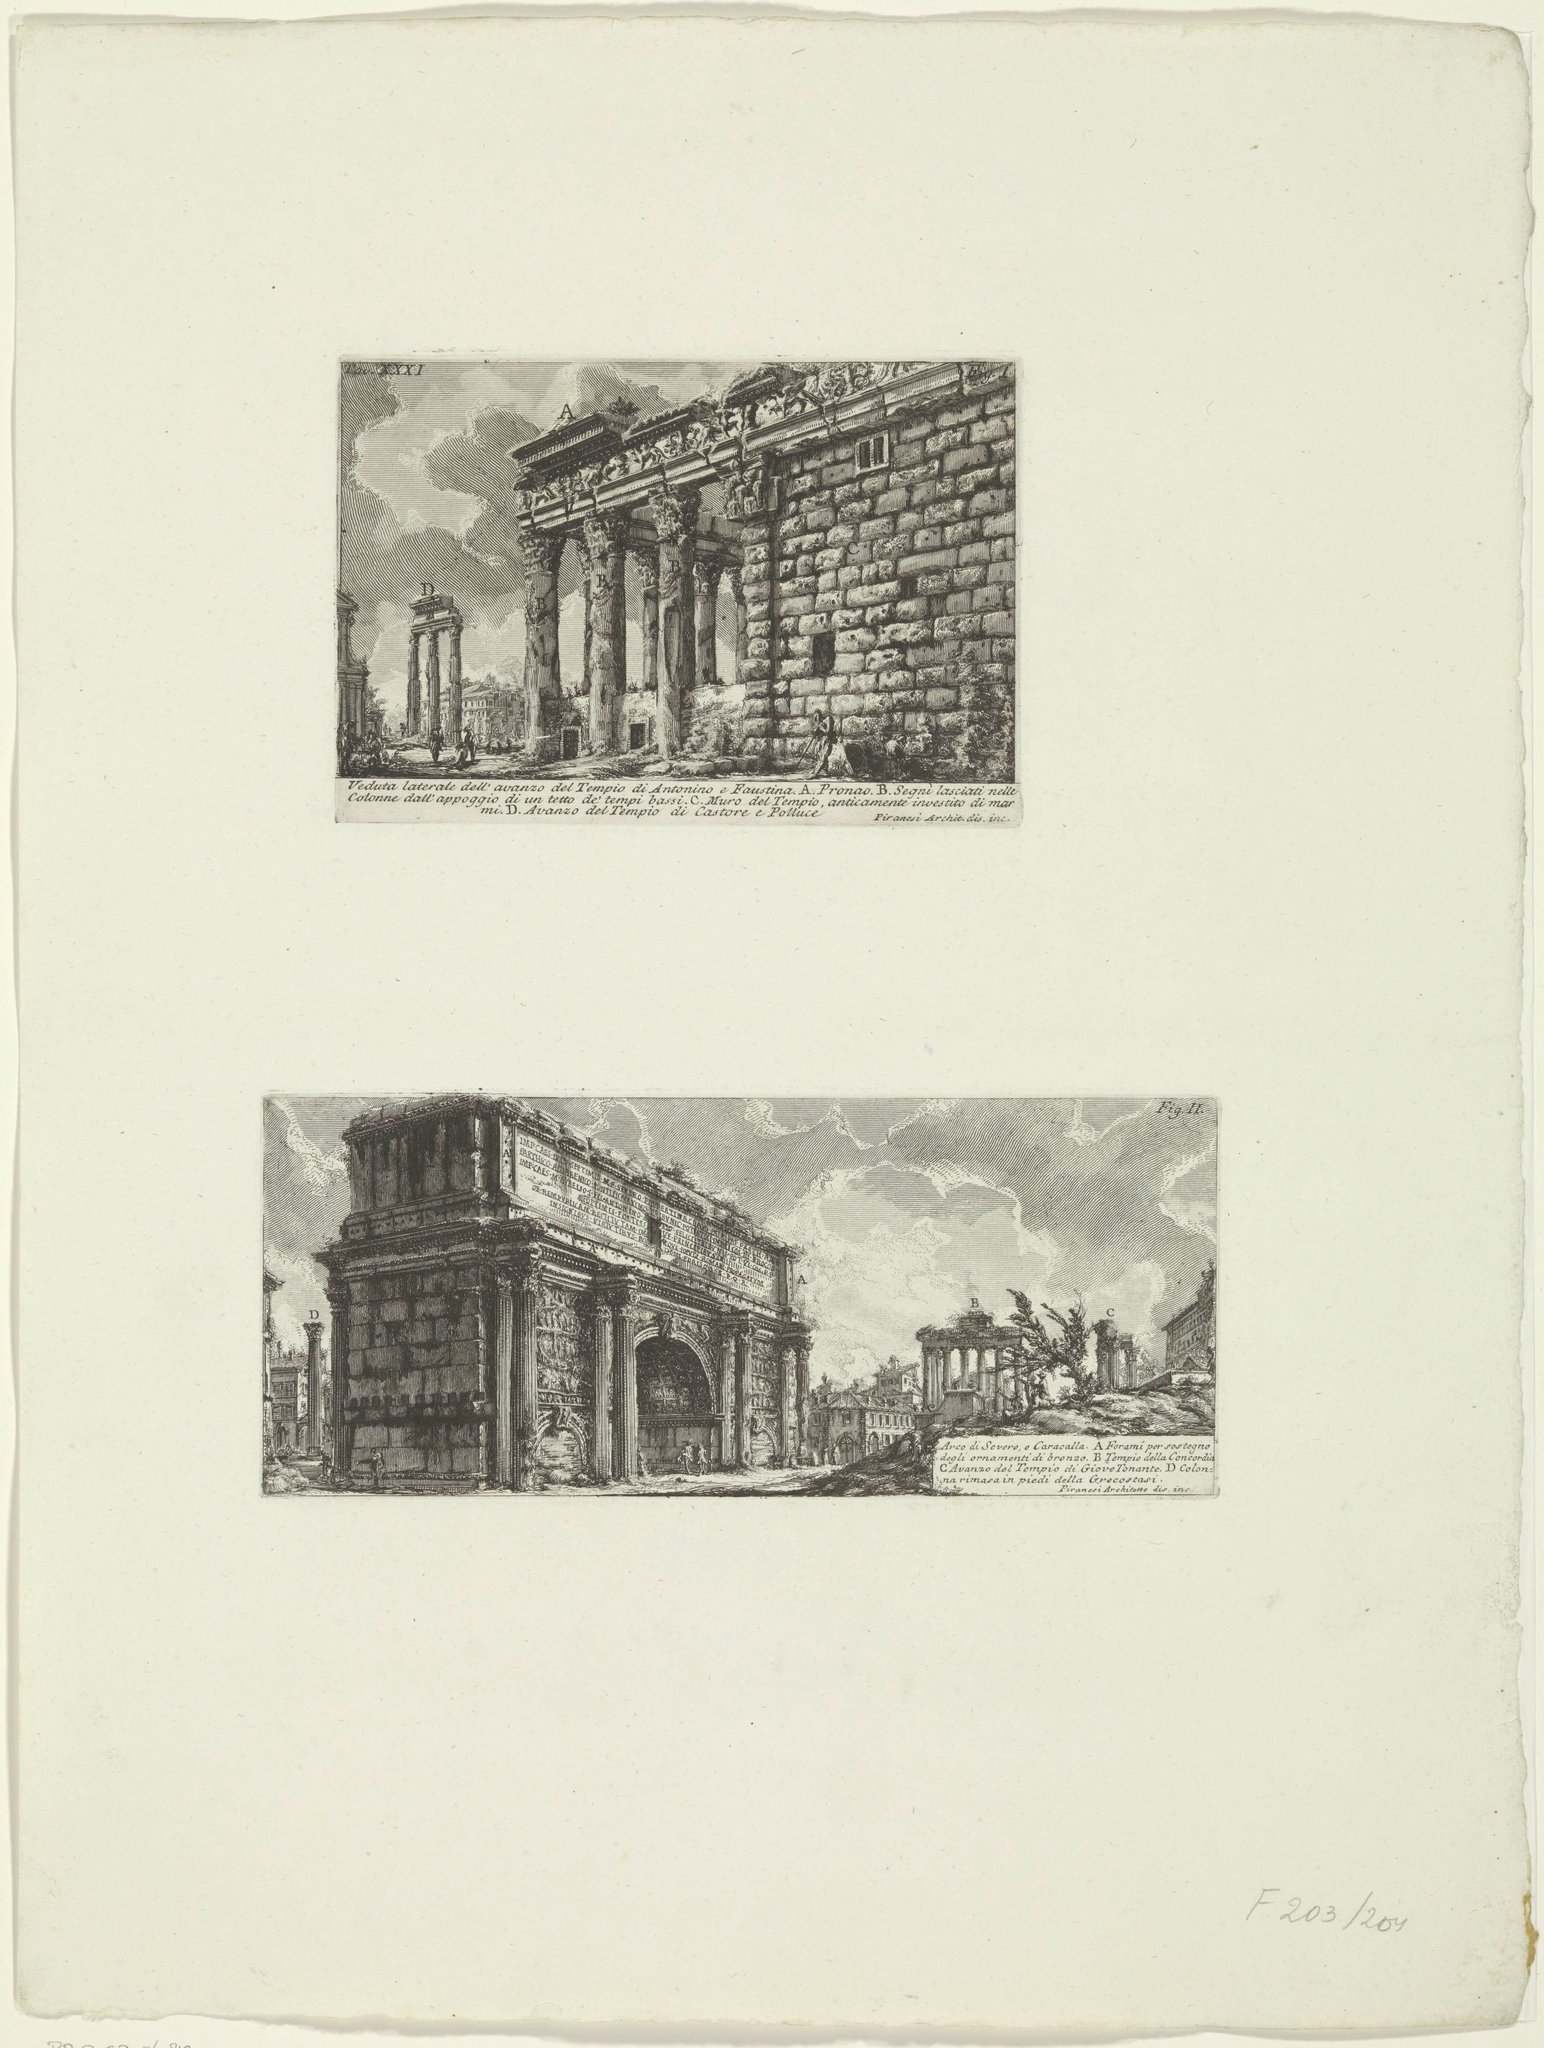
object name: print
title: Tempel van Antoninus en Faustina en Boog van Septimius Severus te Rome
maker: giovanni battista piranesi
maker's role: designer, draughtsman, print maker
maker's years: 1720-1778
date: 1756-1757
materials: paper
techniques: etching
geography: rome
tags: ruin of a building ~ architecture, triumphal arch, temple, shrine ~ roman religion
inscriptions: collector's mark: Lugt 2228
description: Blad met twee voorstellingen van het Forum Romanum te Rome. Boven: op de voorgrond restanten van de Tempel van Antoninus en Faustina. Links de drie resterende zuilen van de Tempel van Castor en Pollux. Genummerd linksboven: Tav. XXXI. Genummerd rechtsboven: Fig. I. Titel en verklarende lijst met letters in ondermarge. Onder: op de voorgrond de Boog van Septimius Severus. Rechts de restanten van de Tempel van Saturnus (op prent geïdentificeerd als Tempel van Concordia) en de Tempel van Vespasianus en Titus (op prent geïdentificeerd als Tempel van Jupiter Tonans). Genummerd rechtsboven: Fig. II. Titel en verklarende lijst met letters in ondermarge.